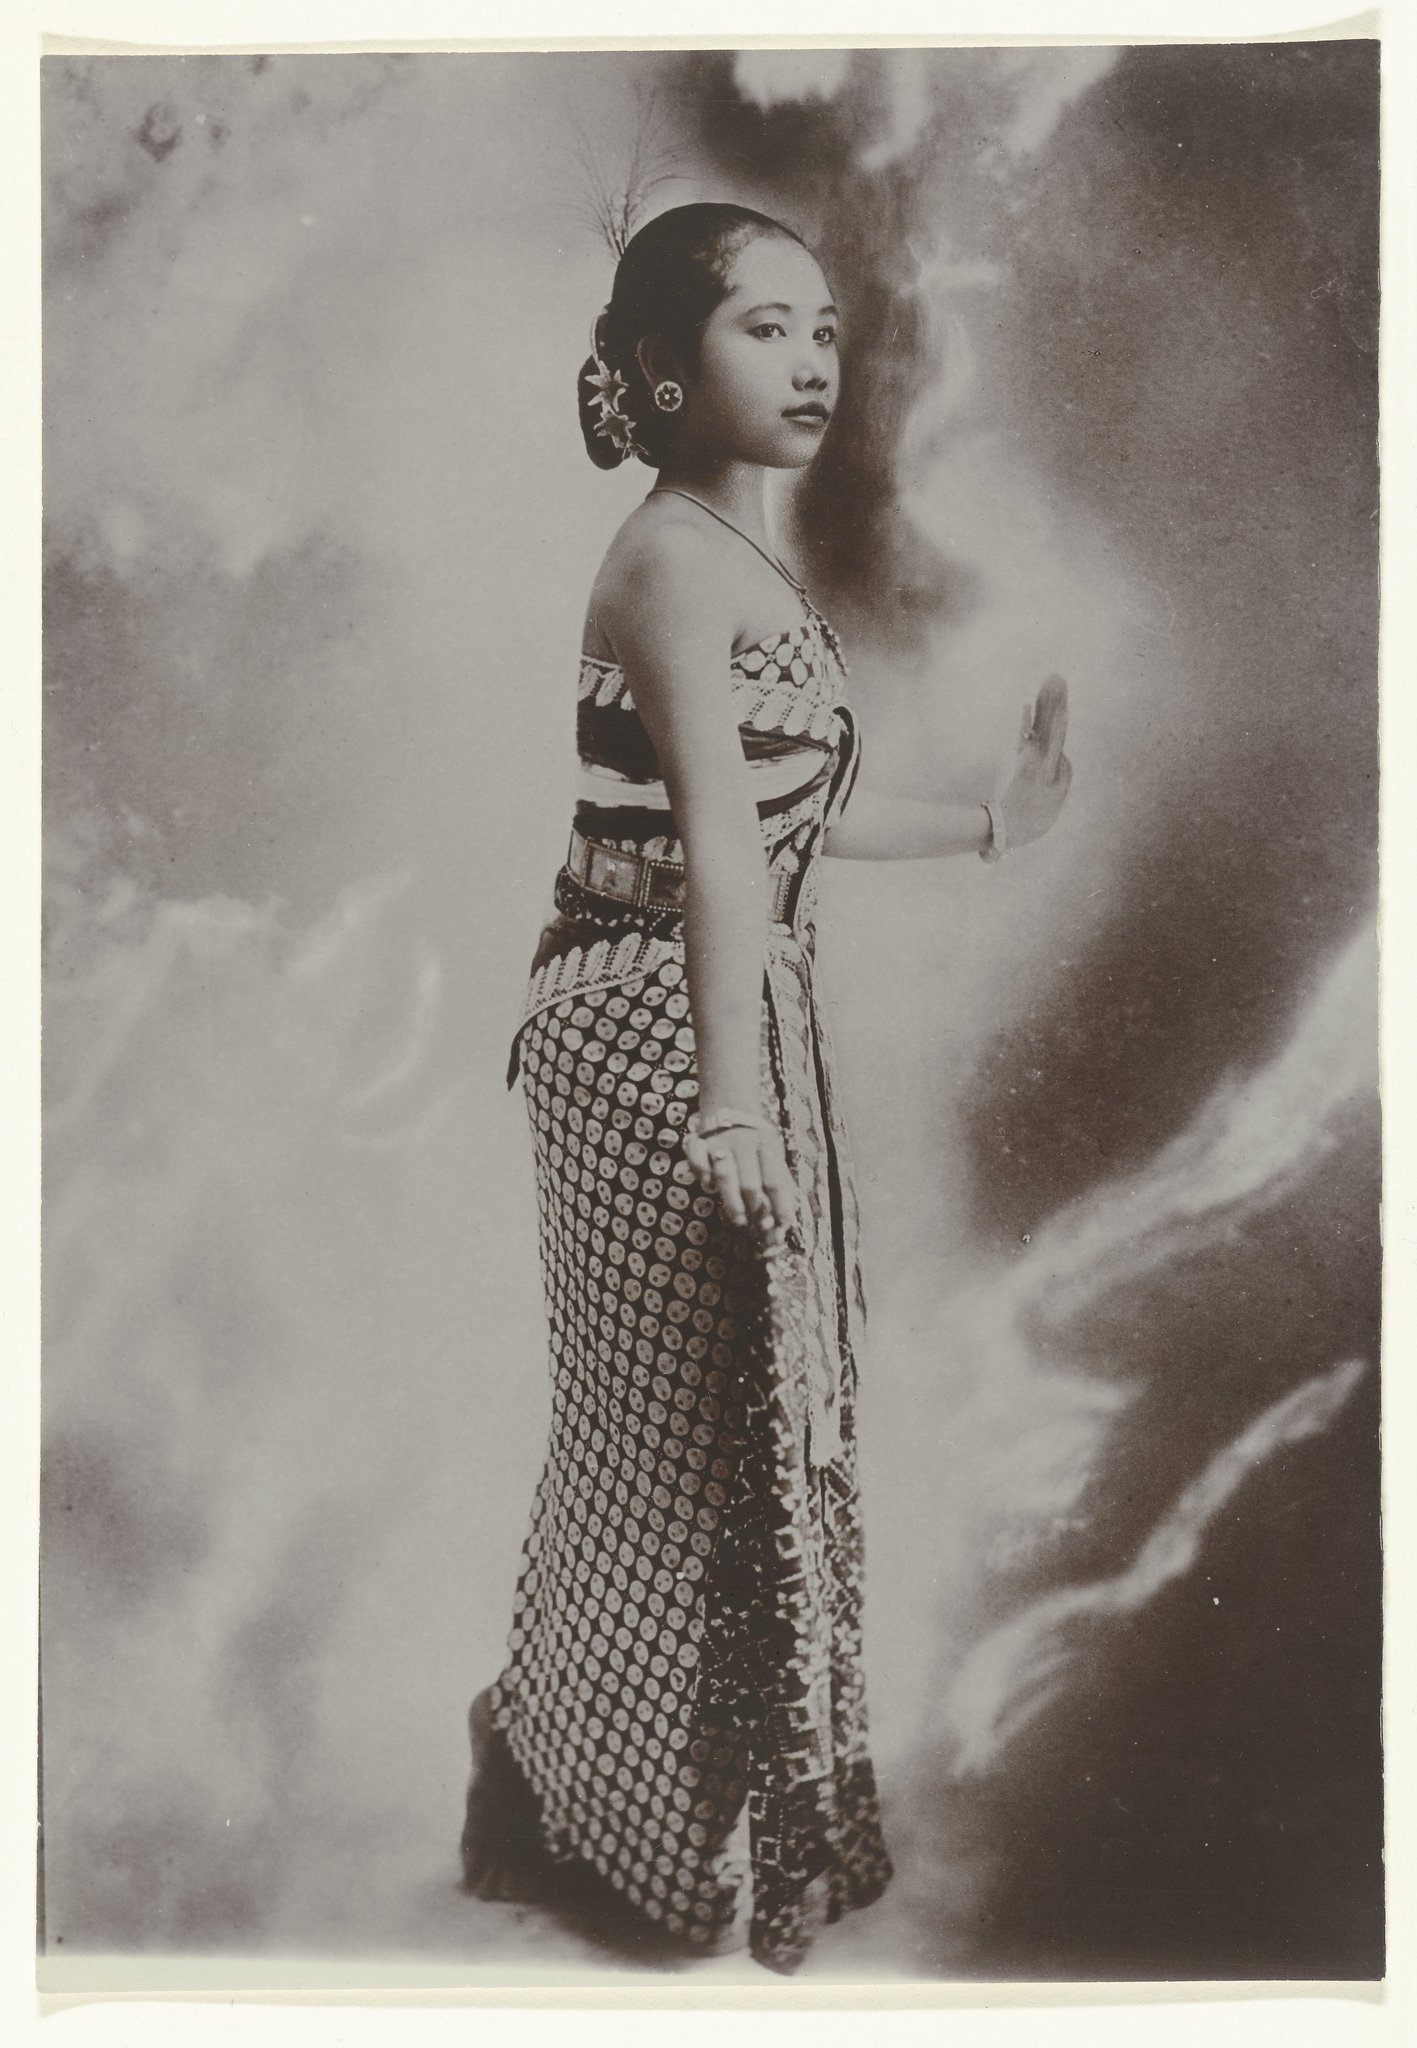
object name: photograph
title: Studio Portrait of a Javanese Dancer with Background Light Effects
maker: kassian céphas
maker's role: fotograaf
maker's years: 1845-1912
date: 1867-1910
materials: cardboard, paper, photographic support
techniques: albumen print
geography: java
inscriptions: signature: ‘Cephas photo’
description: The same woman is again shown standing in a position reminiscent of traditional dance, with her left hand raised with her fingers curving backwards. The light effects in the background recall the fleeting clouds associated with heavenly beauty or the swirling waves of the Goddess of the South Sea. At the same time, they lend the photograph a timeless, almost modern quality.